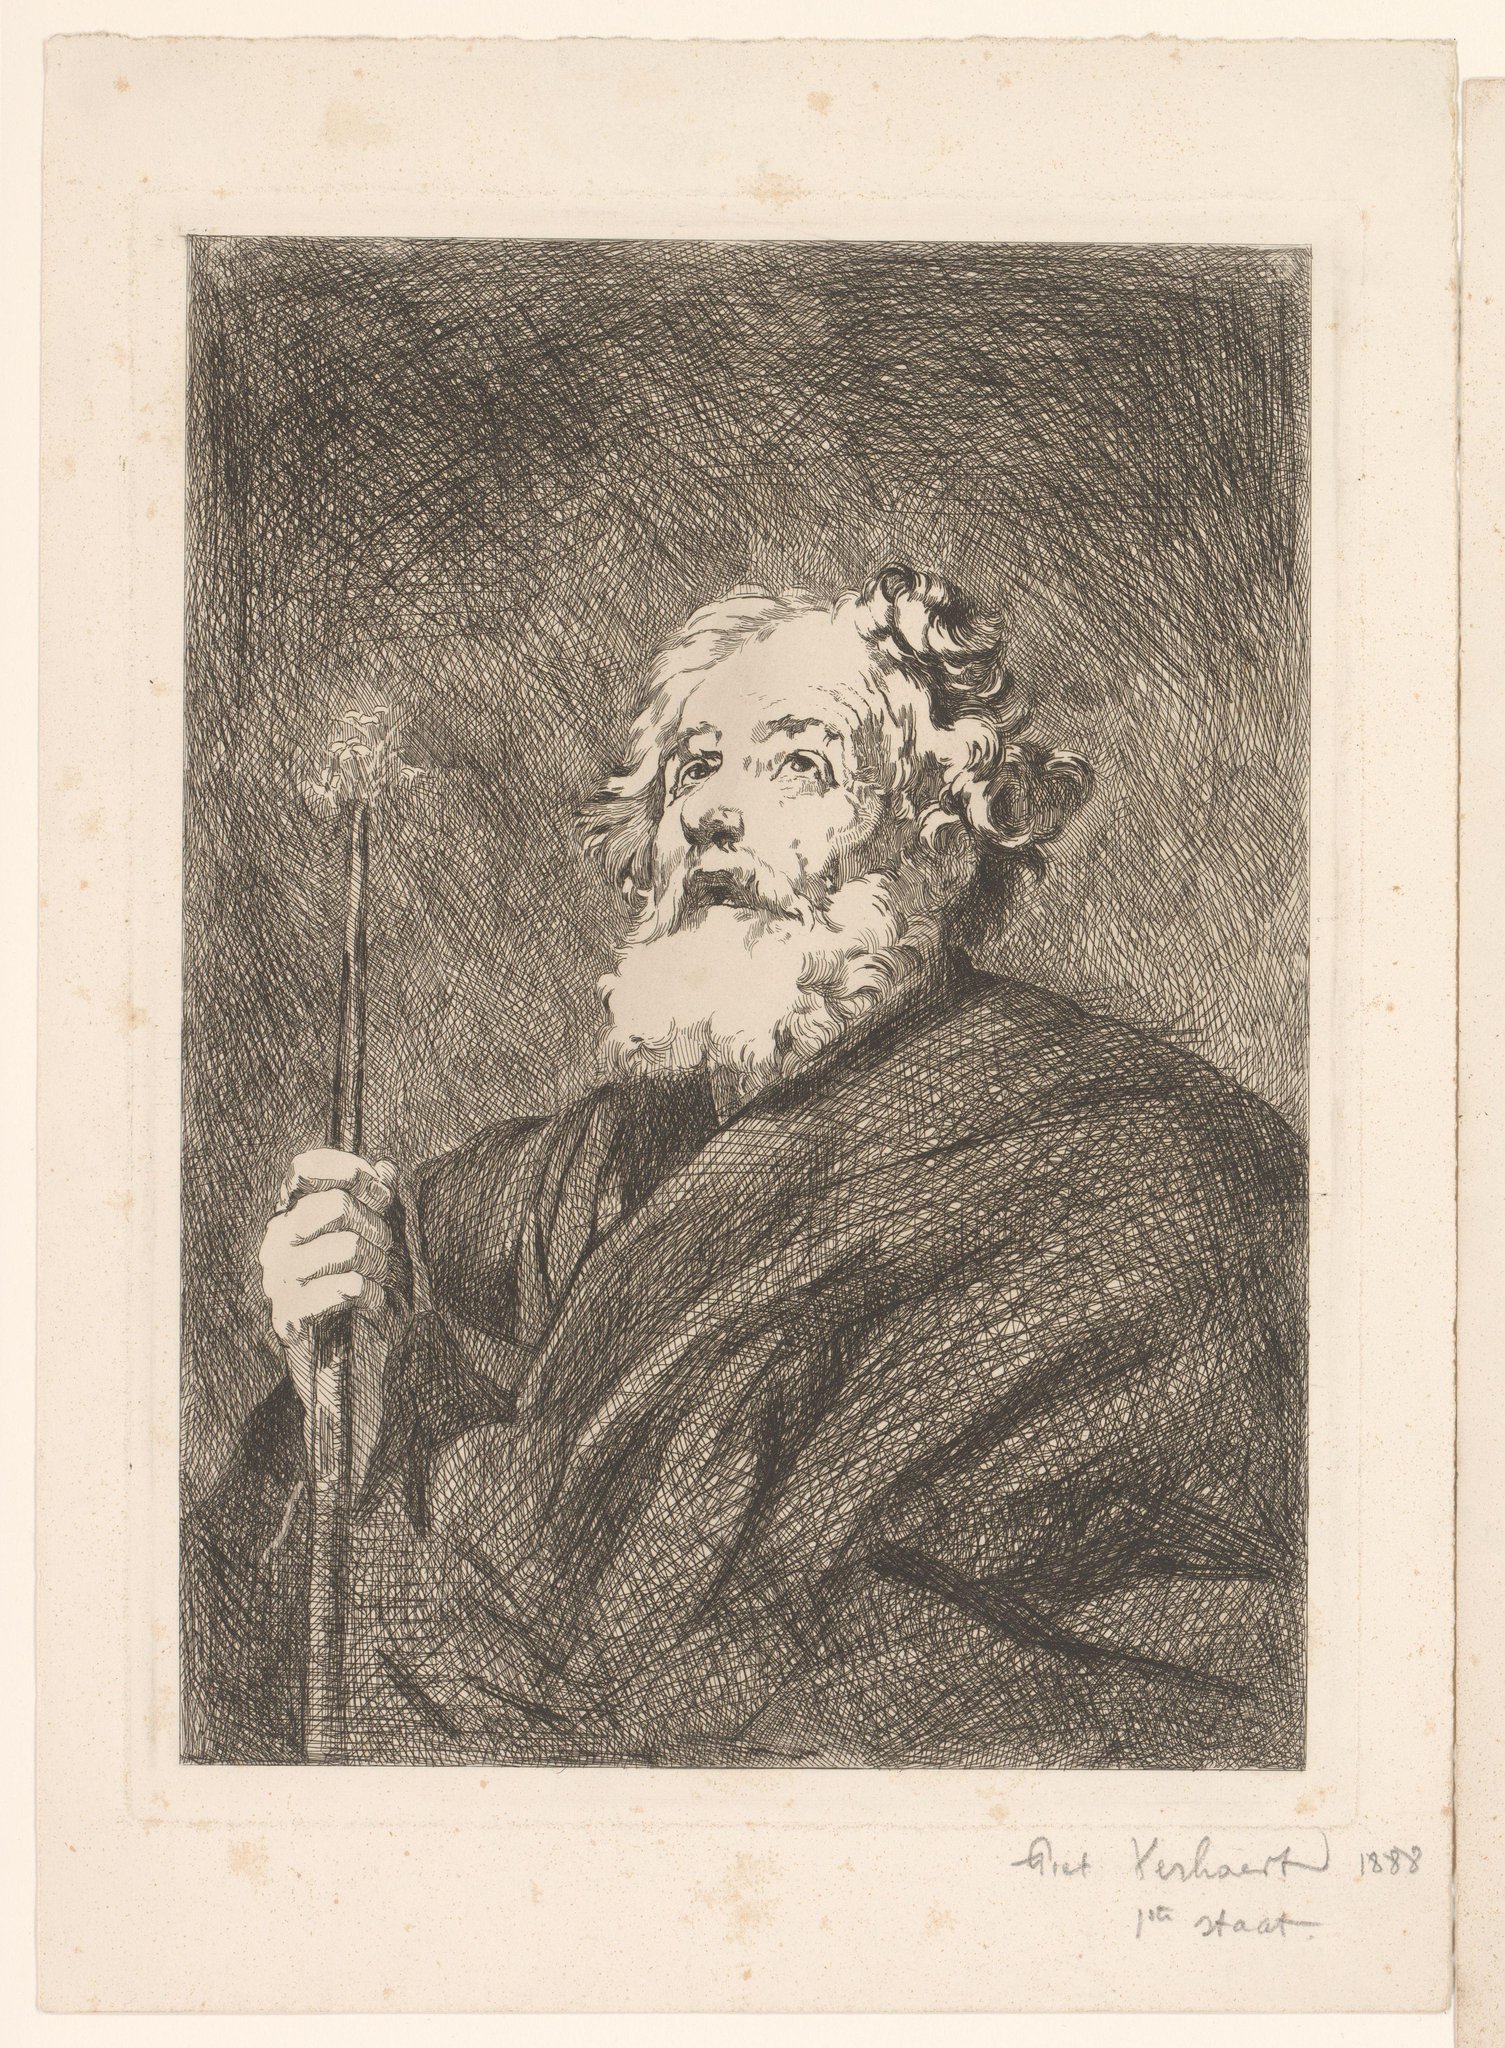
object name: print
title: Heilige Jozef met staf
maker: piet verhaert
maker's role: print maker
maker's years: 1852-1908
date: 1888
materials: paper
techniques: etching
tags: the foster-father of christ, joseph of nazareth, husband of mary; possible attributes: flowering rod or wand, lily, carpenter's tools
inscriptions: inscription: ‘1ste staat’, collector's mark: Lugt 2228